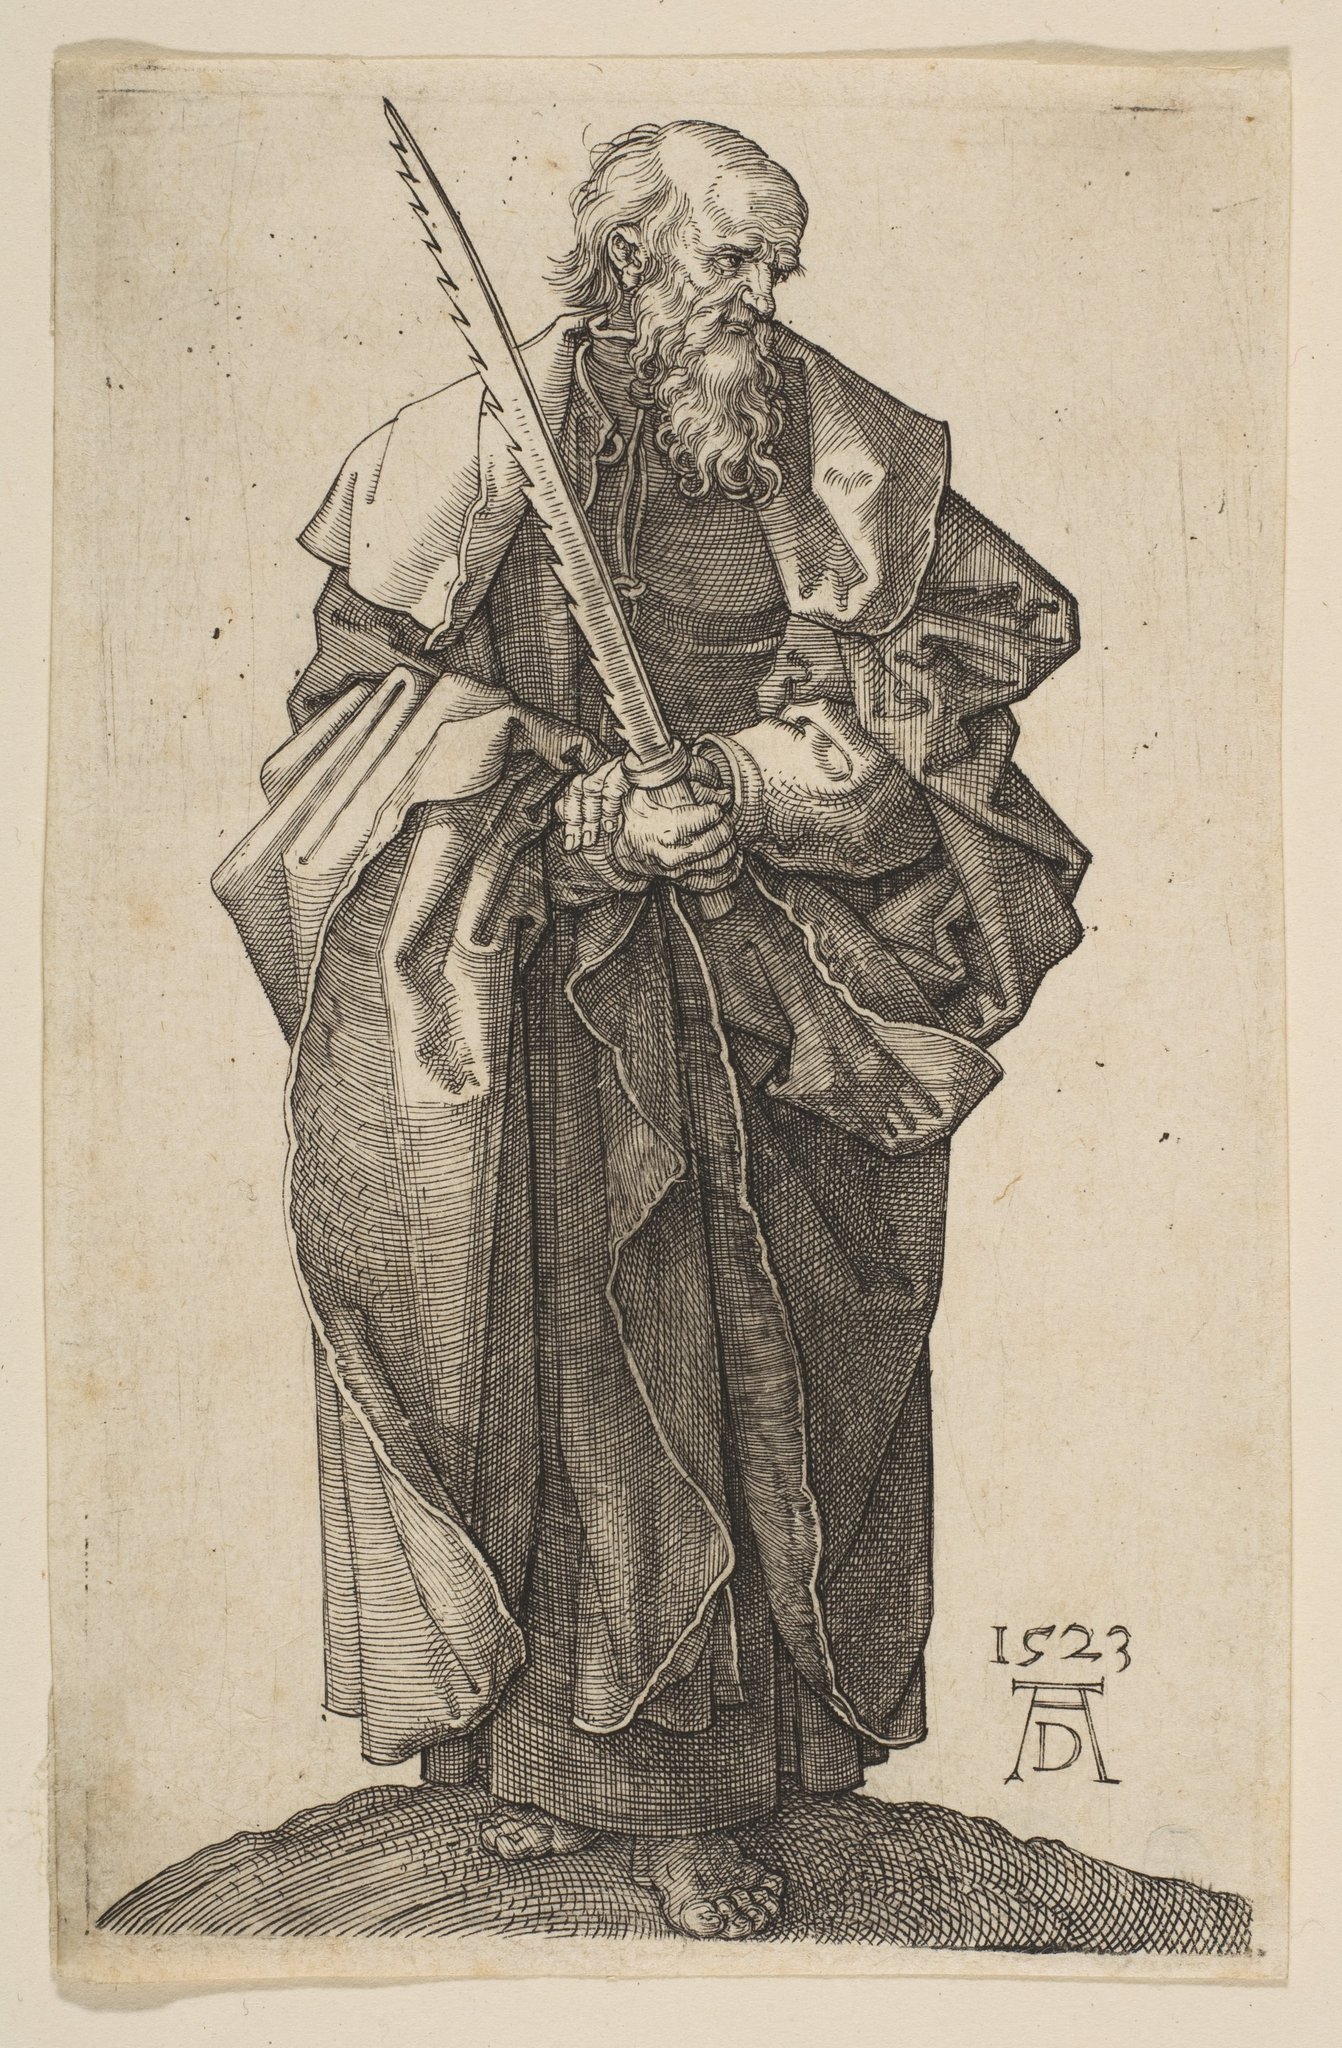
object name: print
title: Saint Simon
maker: albrecht dürer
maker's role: artist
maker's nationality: german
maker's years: 1471-1528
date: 1523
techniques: engraving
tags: swords,saints